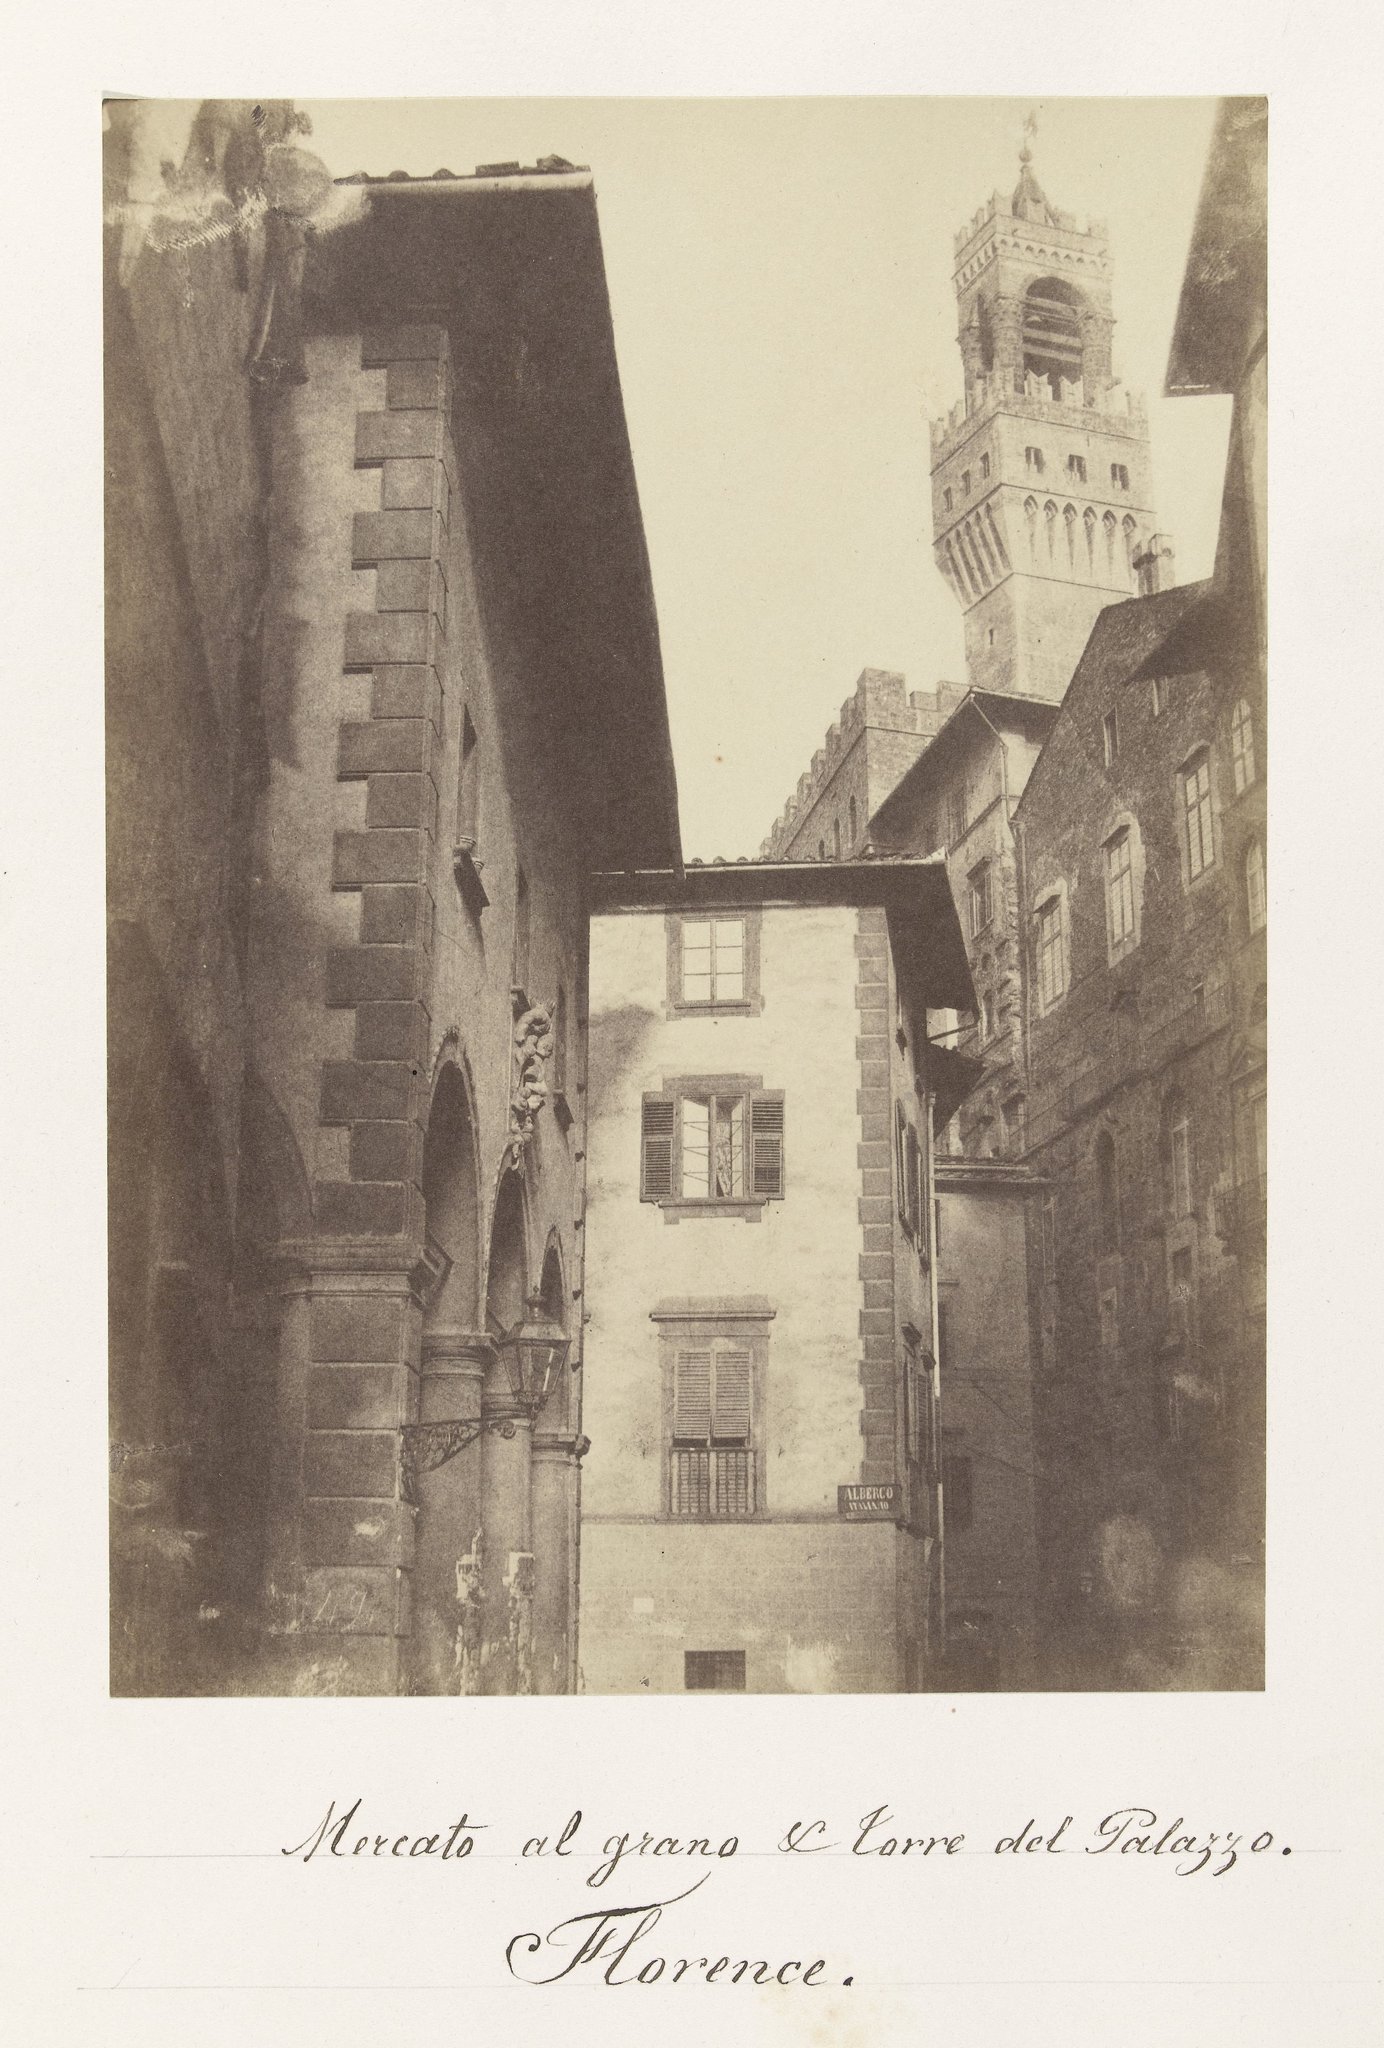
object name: photograph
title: Mercato al grano en Torre del Palazzo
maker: Anonymous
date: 1855-1865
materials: cardboard, photographic support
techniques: salted paper print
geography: florence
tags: exterior ~ representation of a building, tower (of house or building)